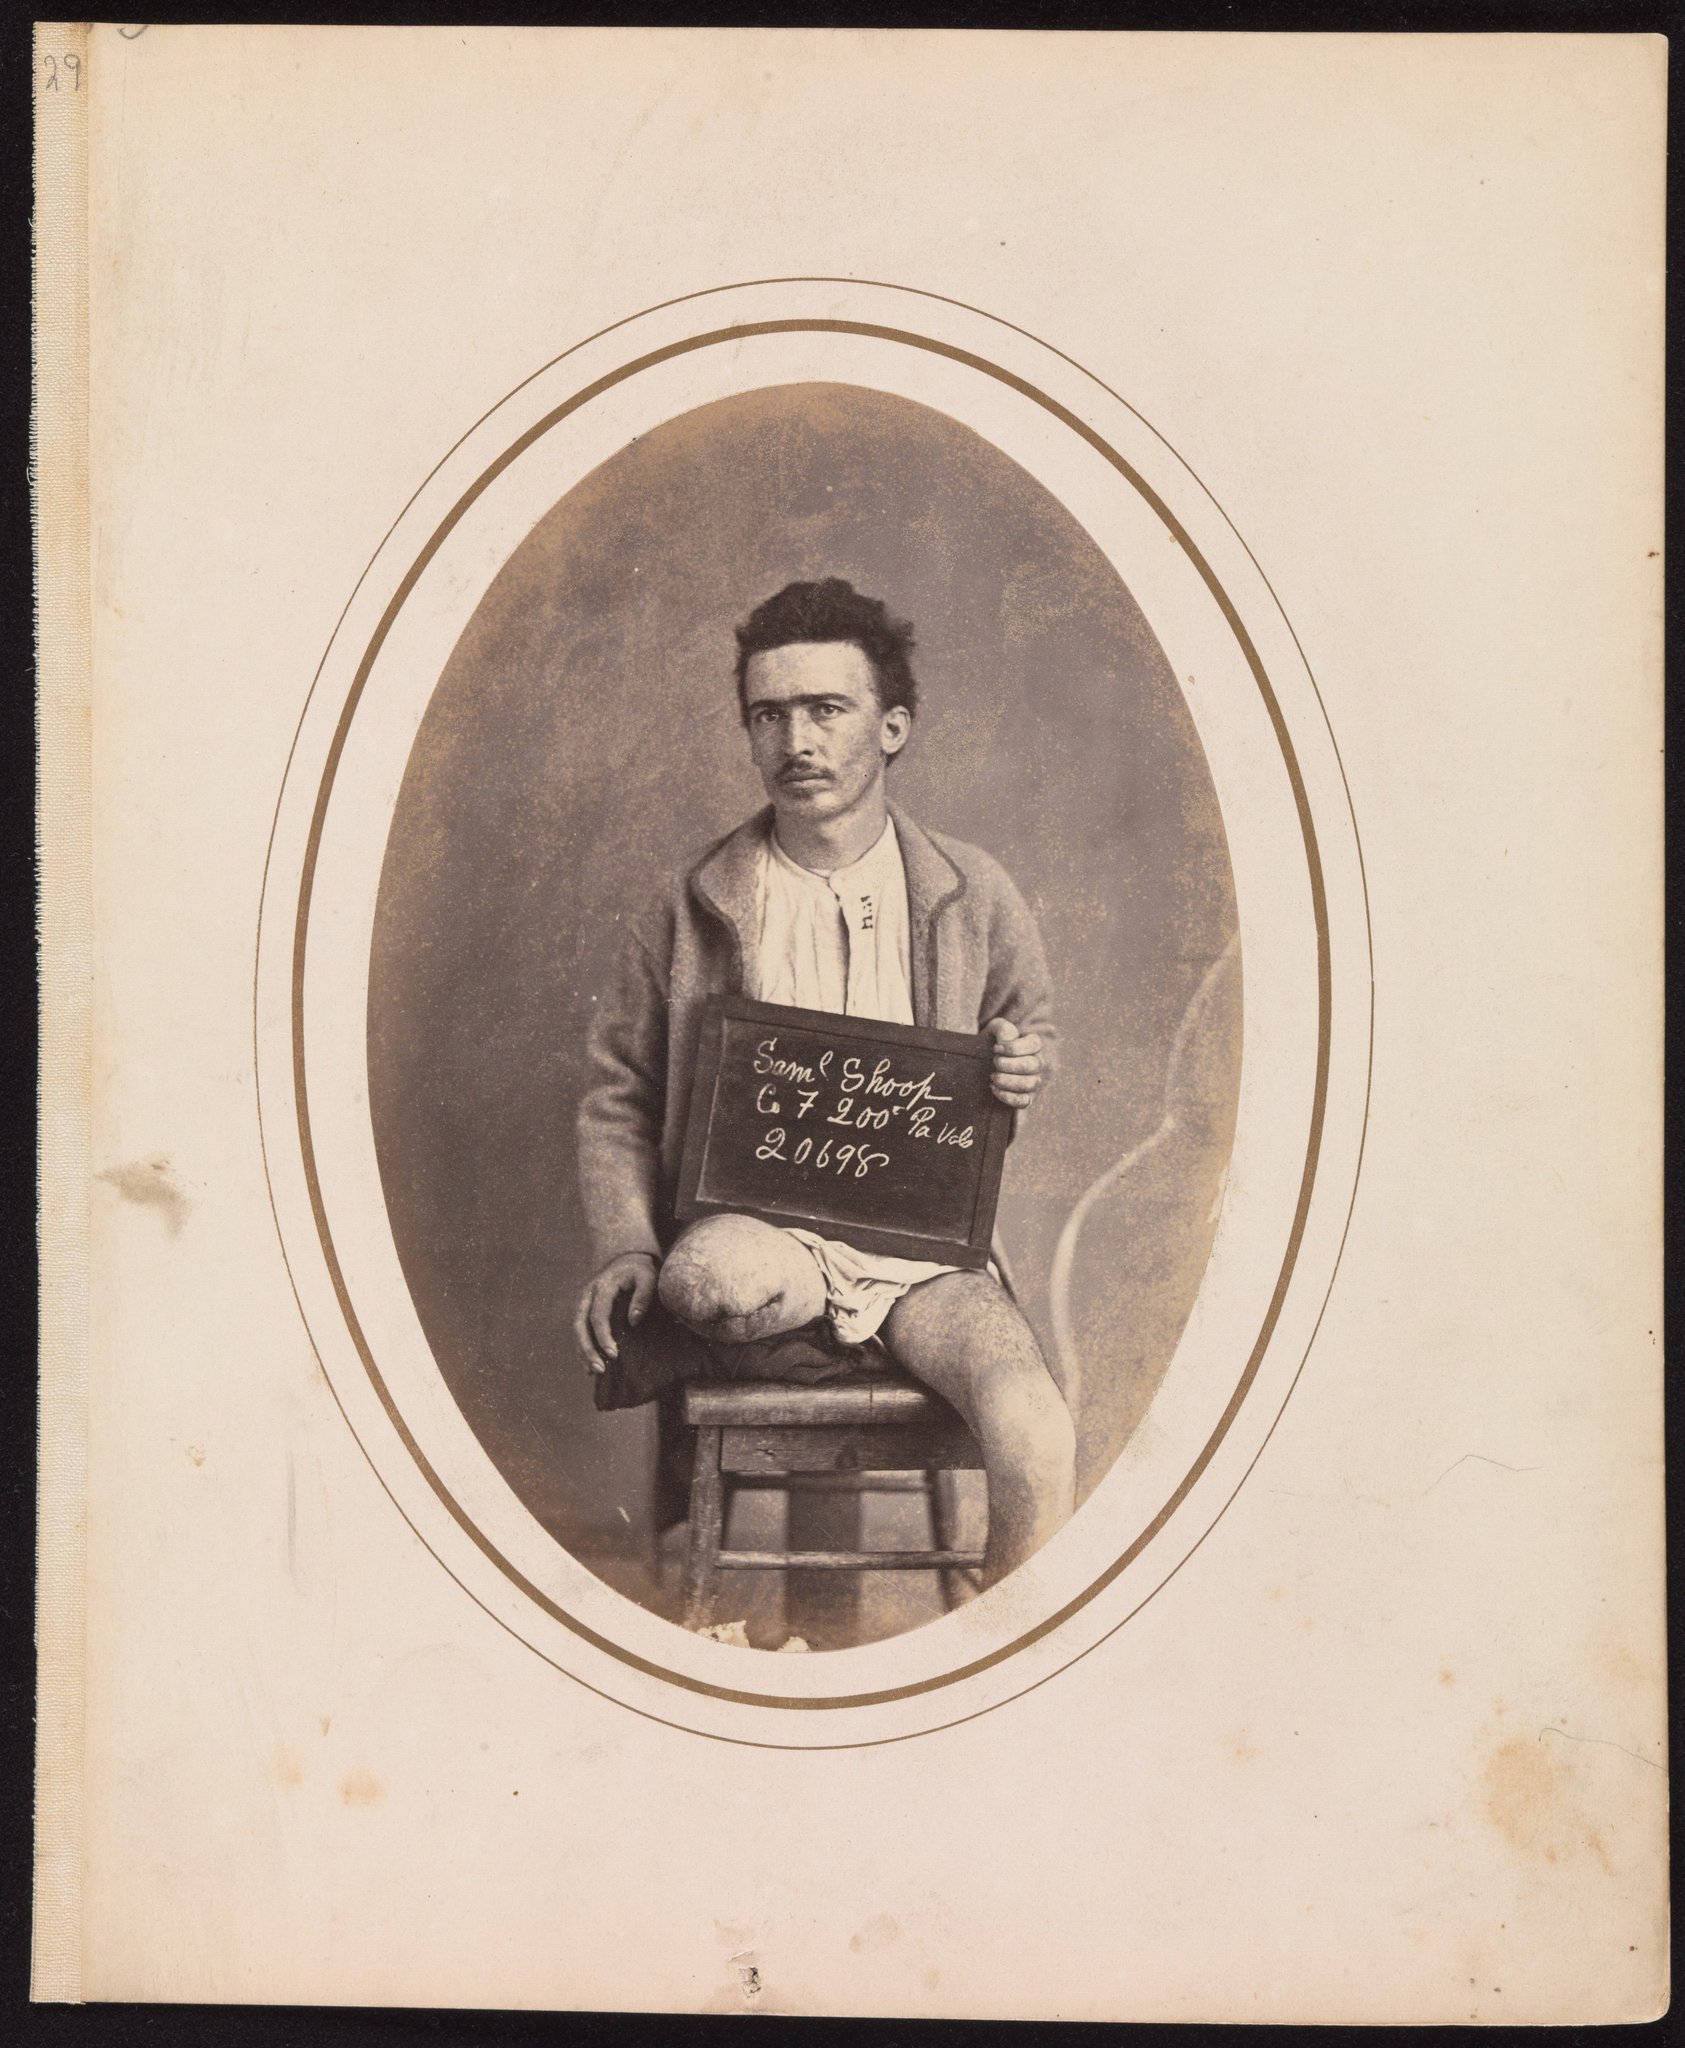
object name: photograph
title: Private Samuel Shoop, Company F, 200th Pennsylvania Infantry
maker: reed brockway bontecou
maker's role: artist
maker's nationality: american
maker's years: 1824-1907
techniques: albumen silver print, glass negative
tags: soldiers,american civil war,men,portraits